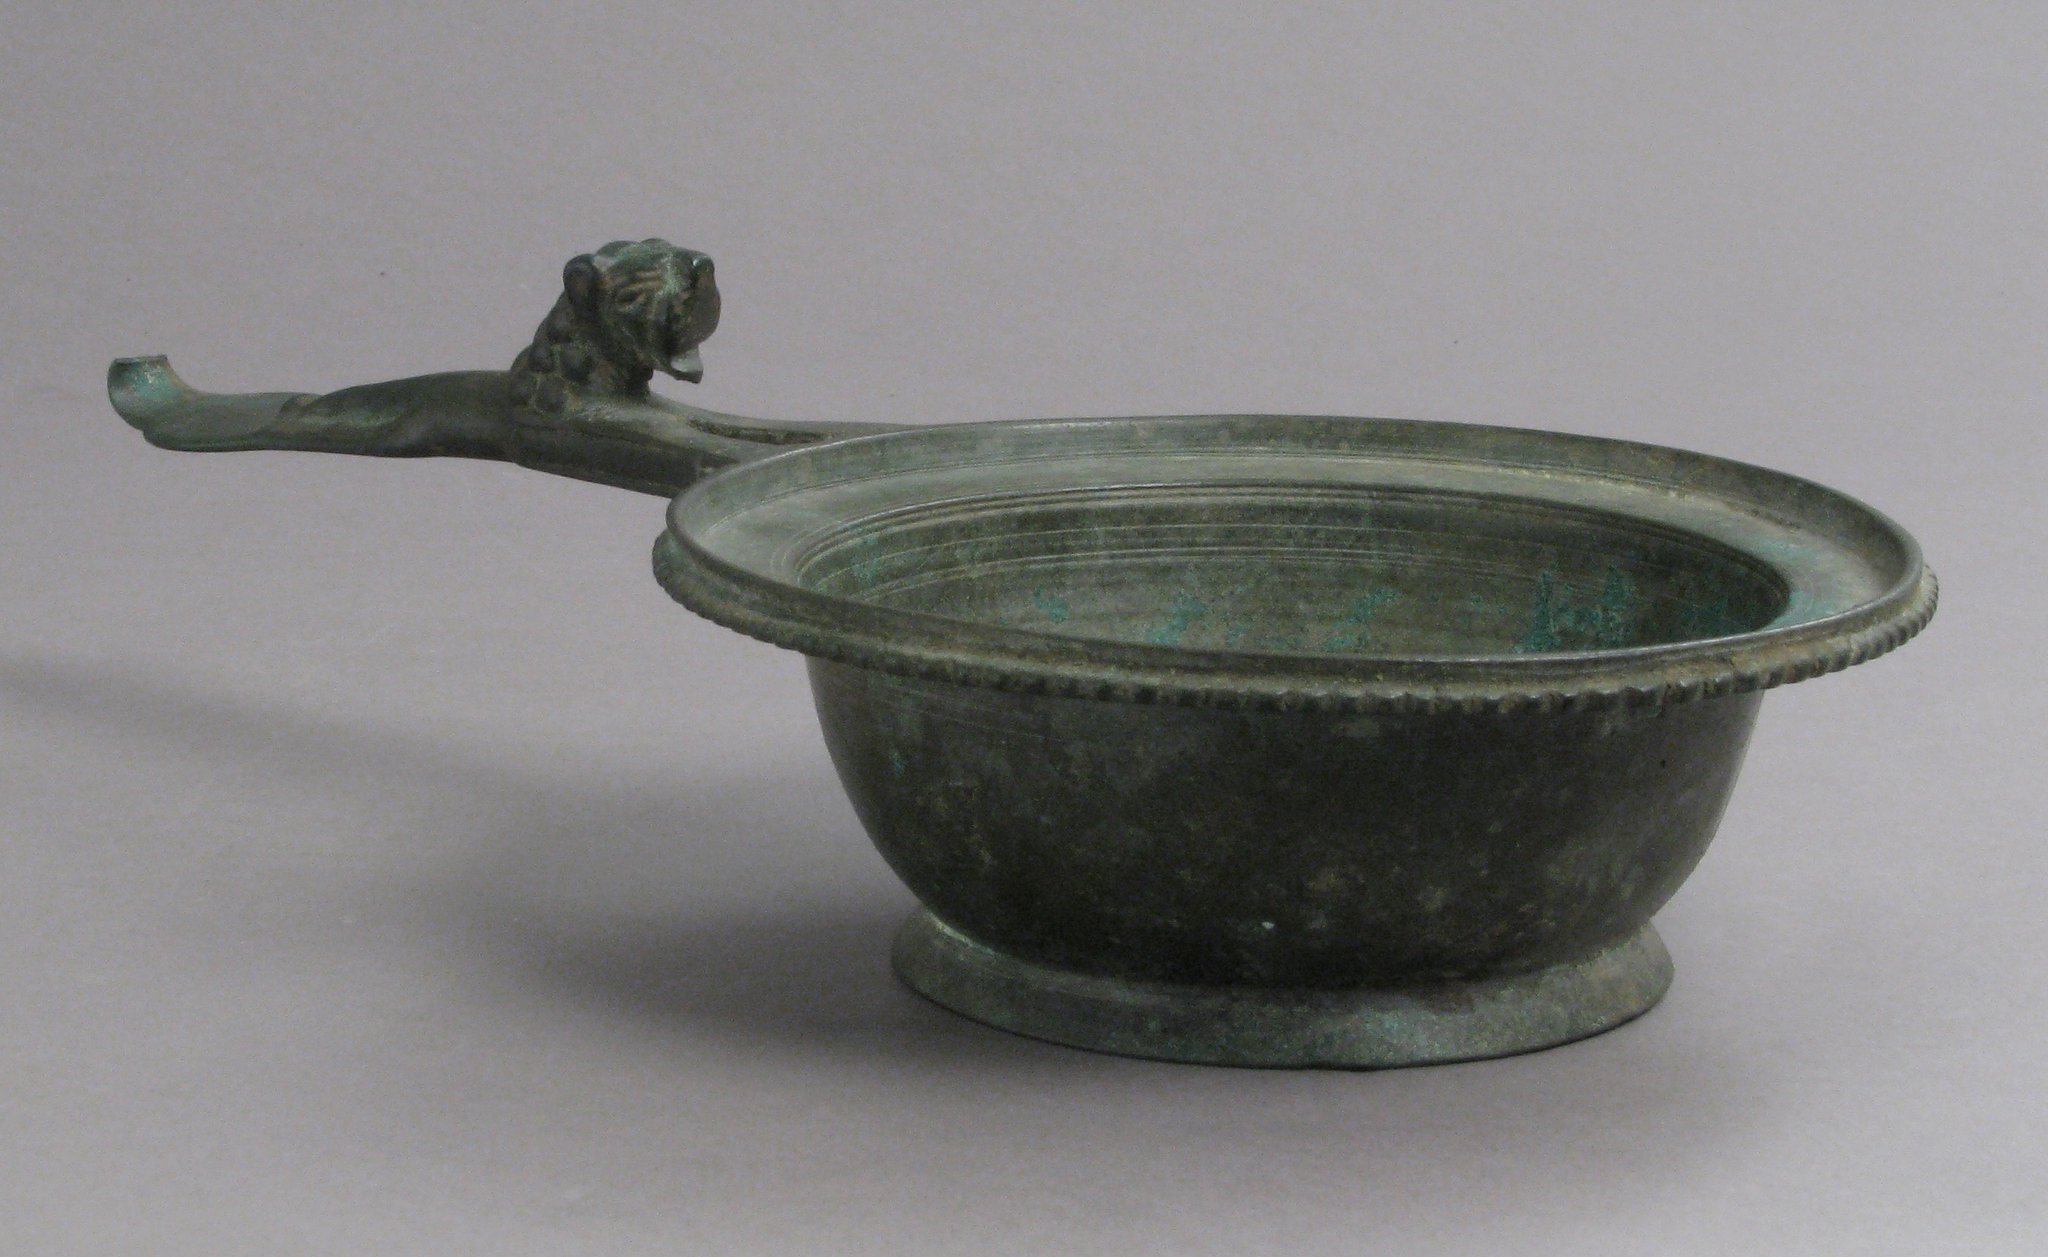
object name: patera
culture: byzantine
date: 401-500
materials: copper alloy